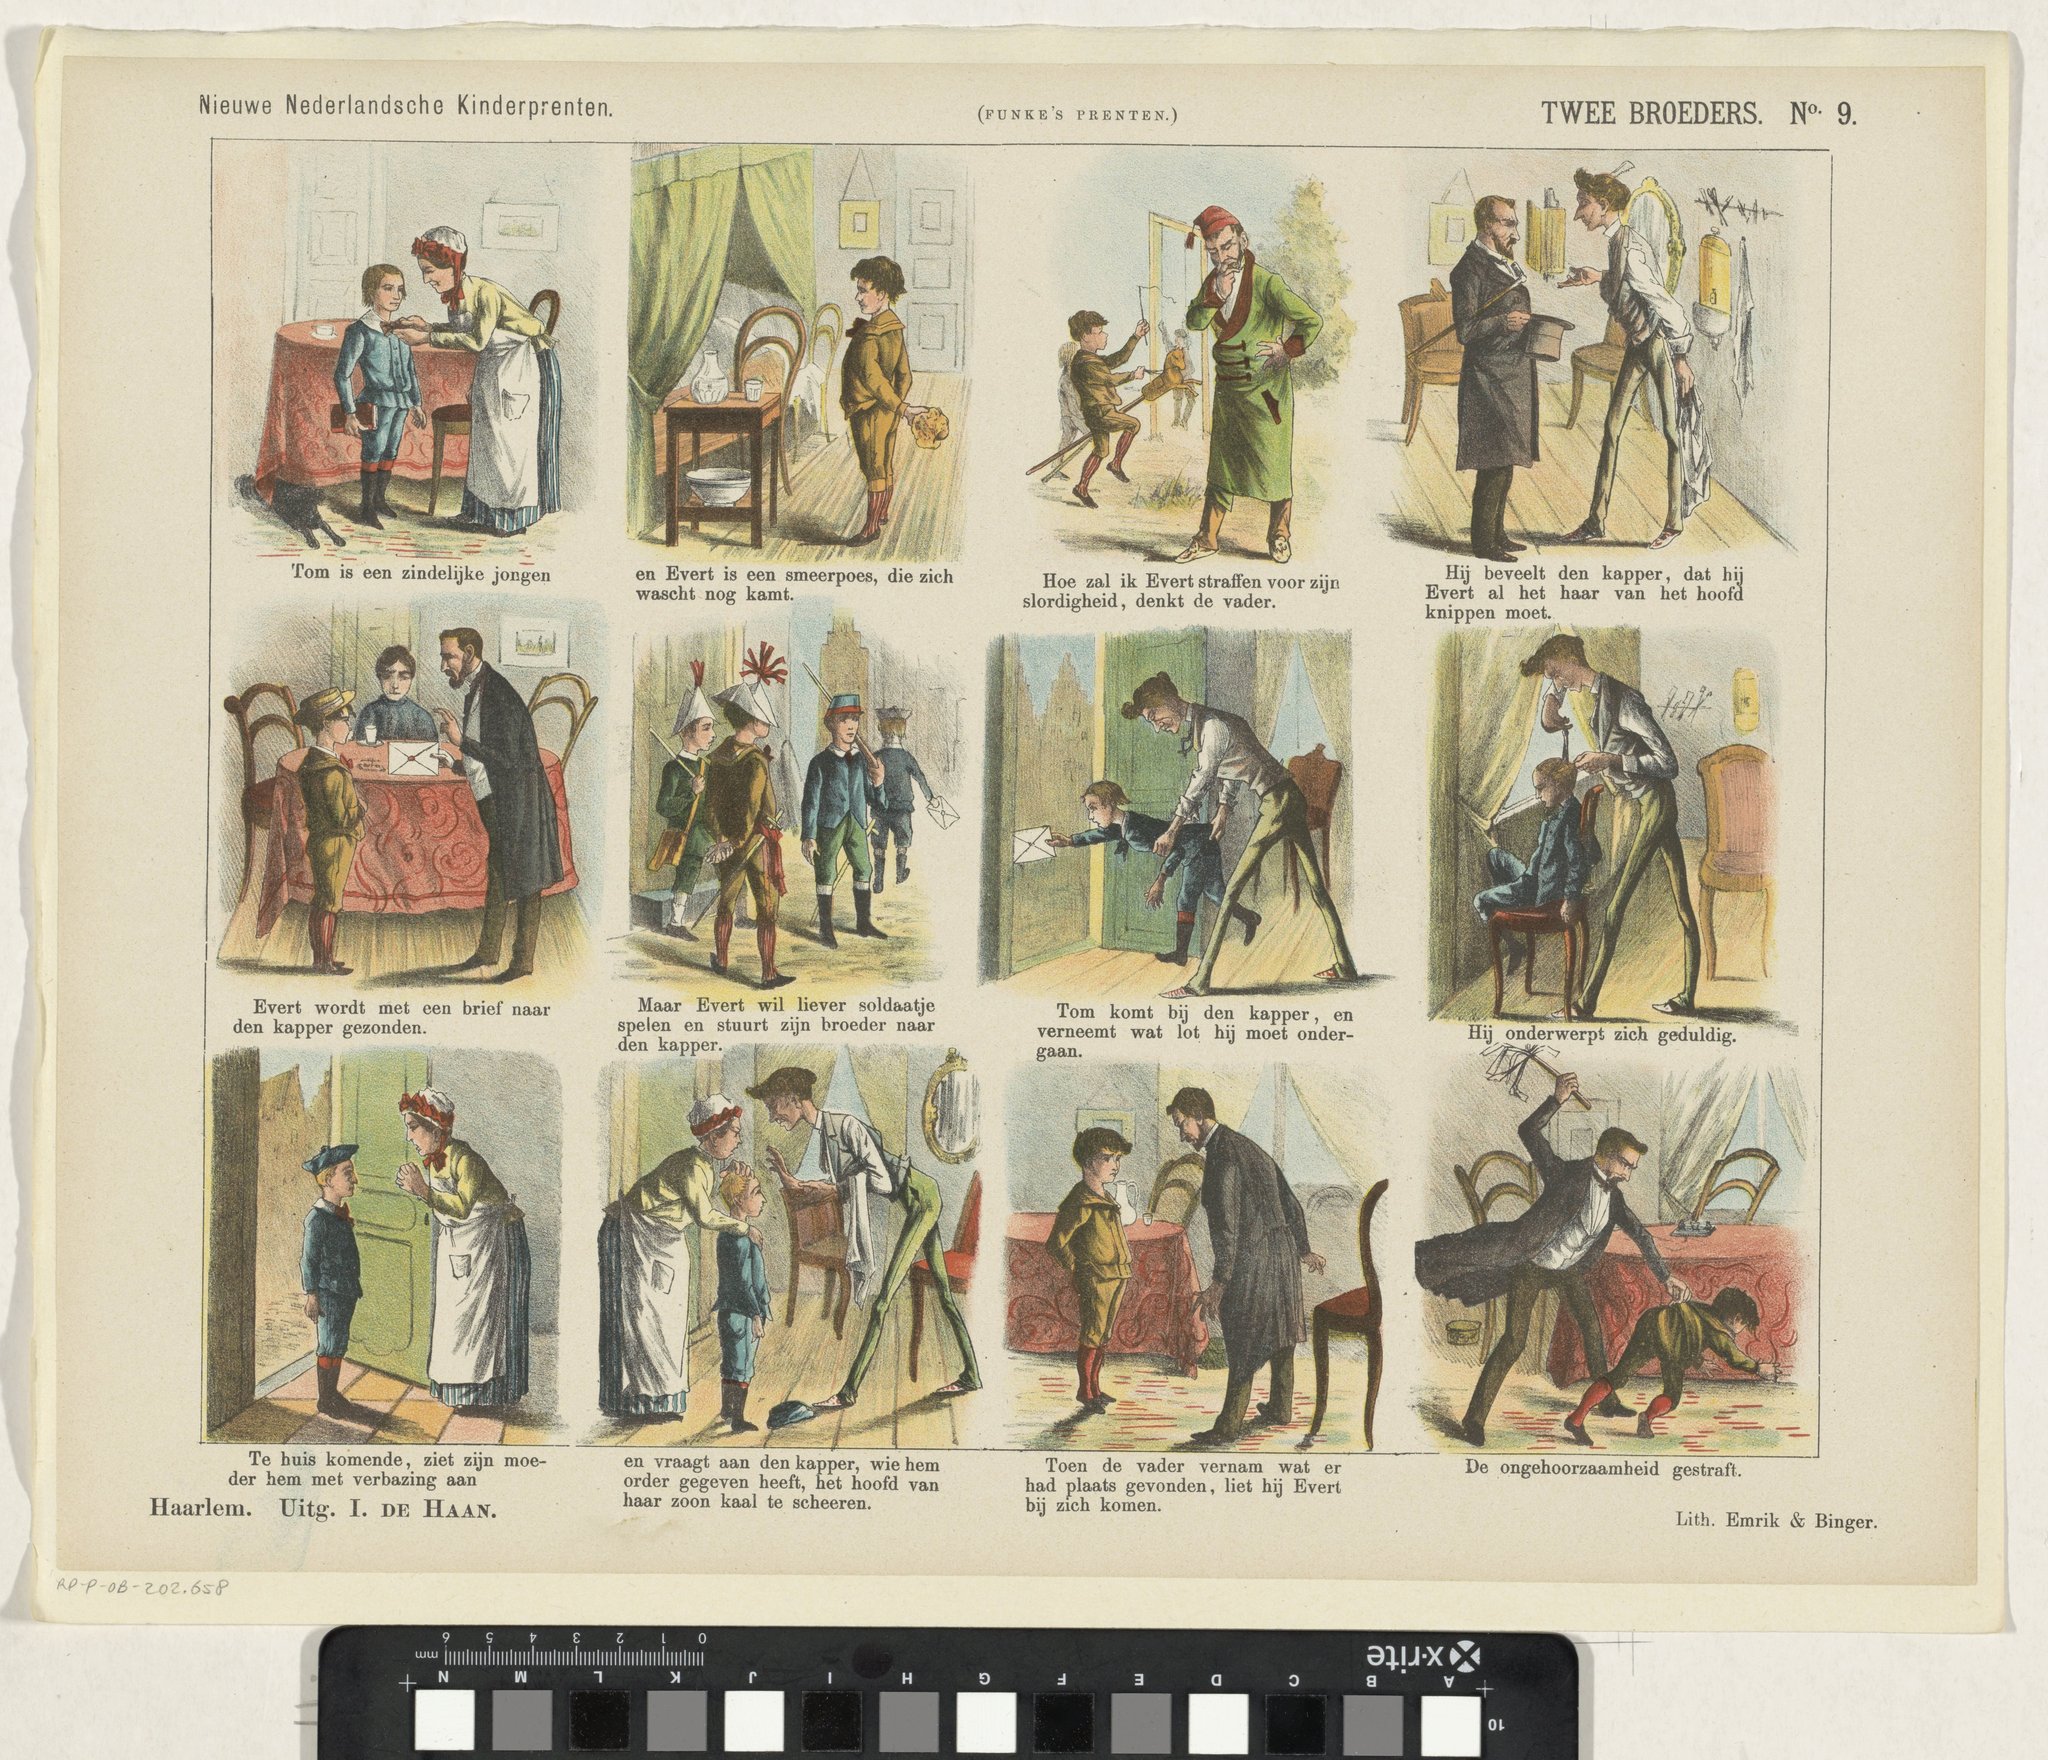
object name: print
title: Twee broeders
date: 1875-1903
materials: paper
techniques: lithograph, letterpress printing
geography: haarlem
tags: correction of naughty children, bad behaviour, good behaviour, barber, barbershop, brothers (second degree family relationships)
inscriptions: collector's mark: Lugt 2760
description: Blad met 12 voorstellingen over de twee broers Evert en Tom. Evert moet naar de kapper maar stuurt zijn broer. Tom wordt door de kapper kaalgeschoren. Evert wordt door zijn vader gestraft. Onder elke afbeelding een onderschrift. Genummerd rechtsboven: No. 9.